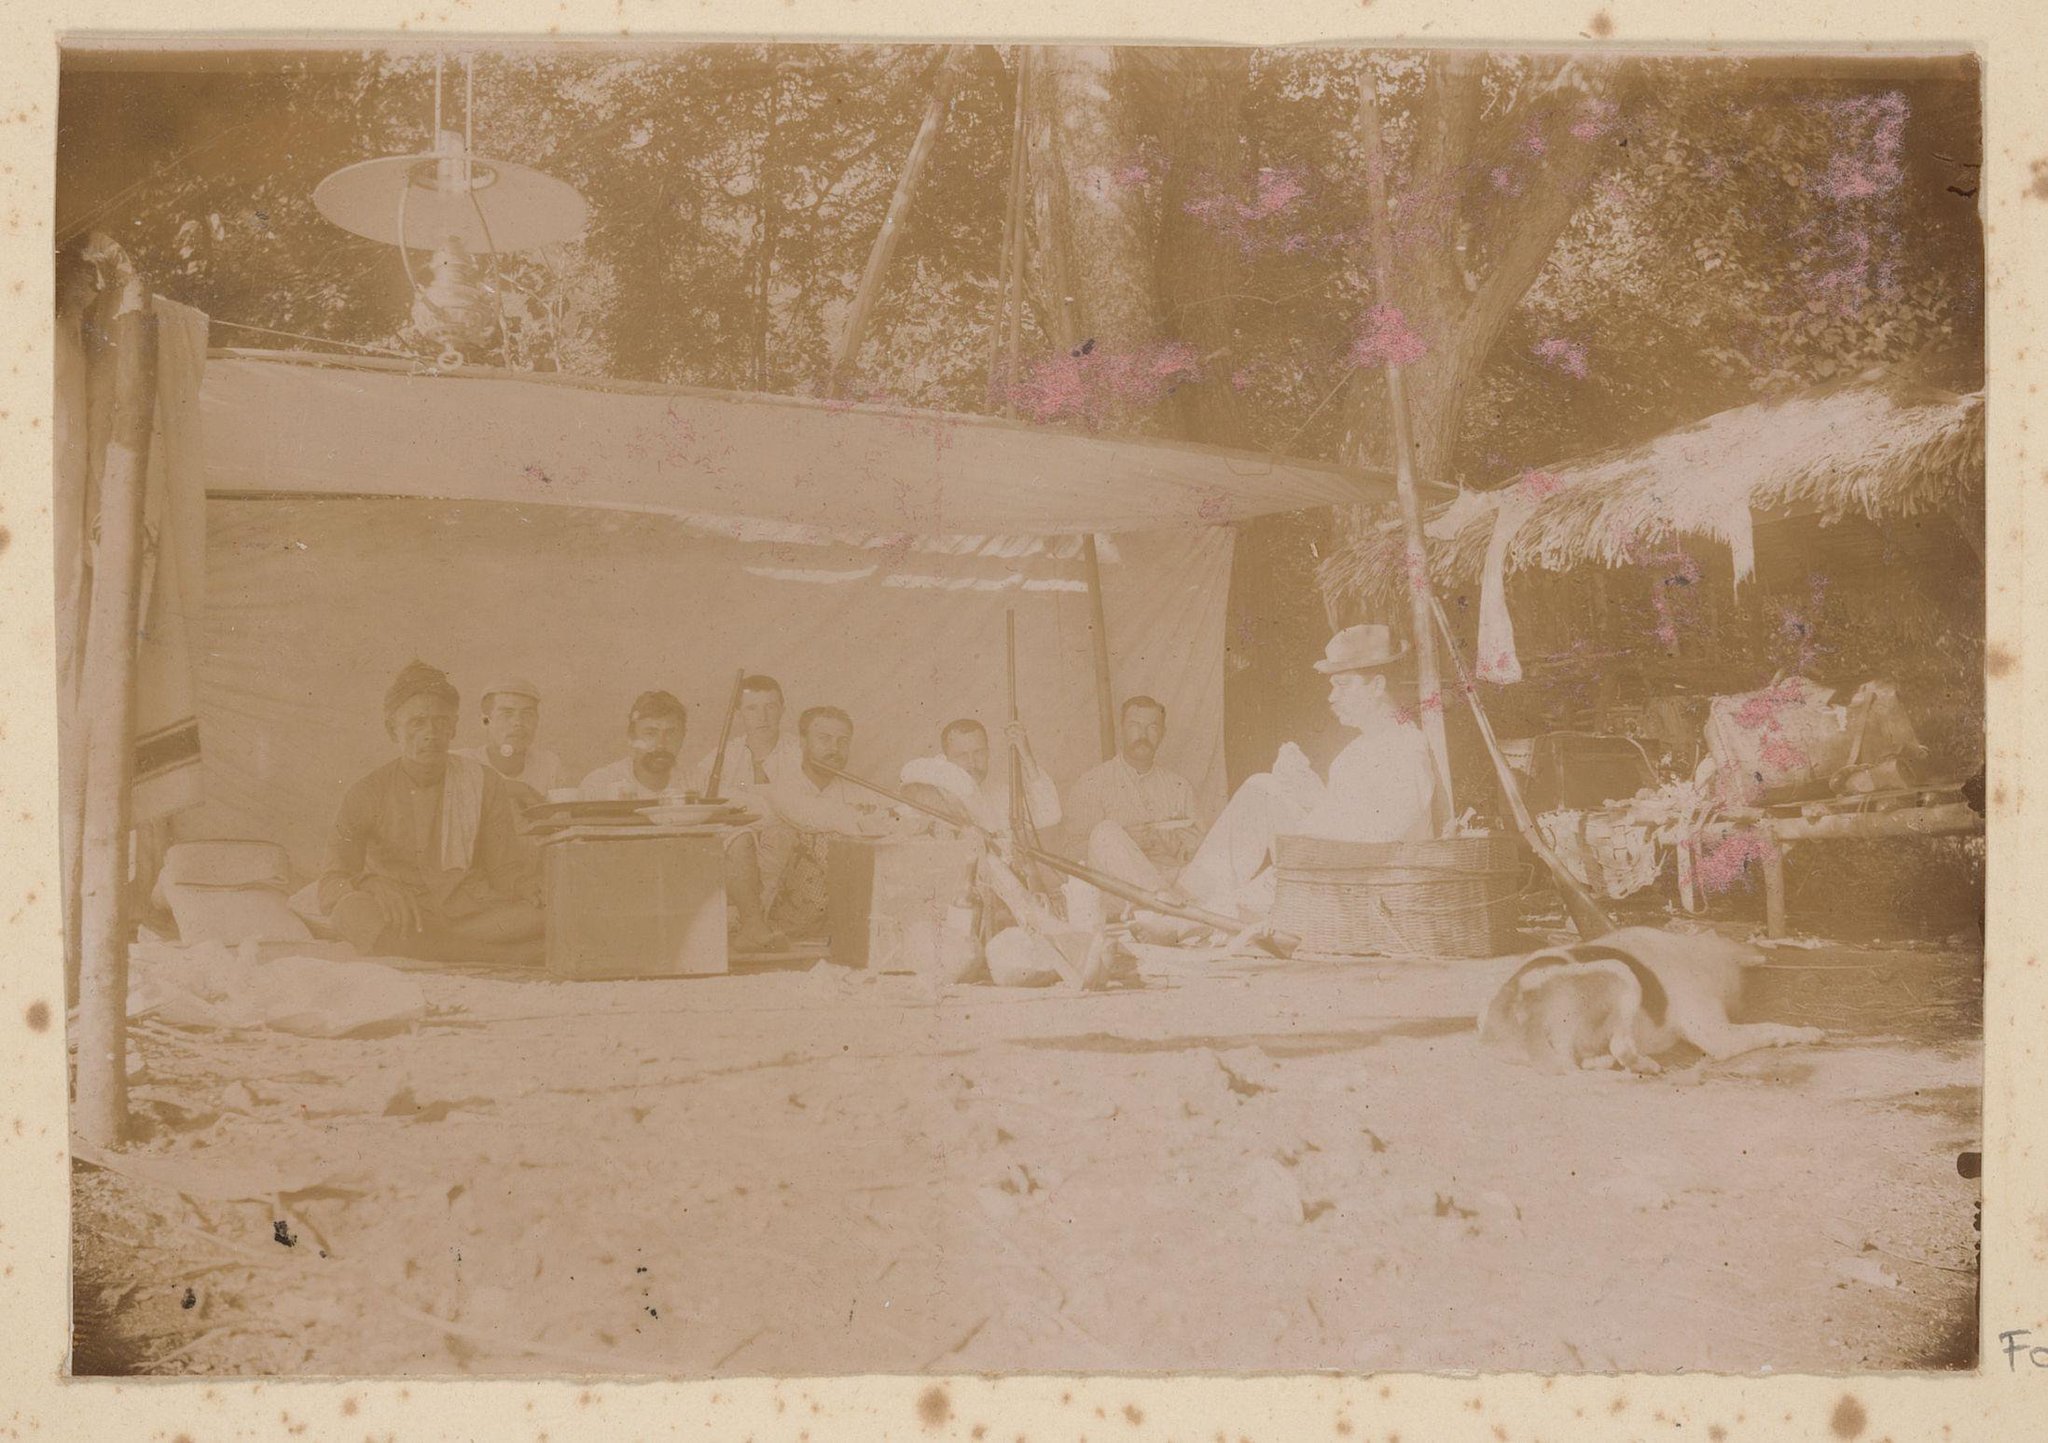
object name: photograph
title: Groep Nederlandse mannen en een Indonesische man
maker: Anonymous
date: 1890-1910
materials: photographic support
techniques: daylight paper print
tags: asiatic races and peoples (indonesians), adult man, europeans (with name), anonymous historical persons portrayed in a group, in a group-portrait, dutch east indies, the